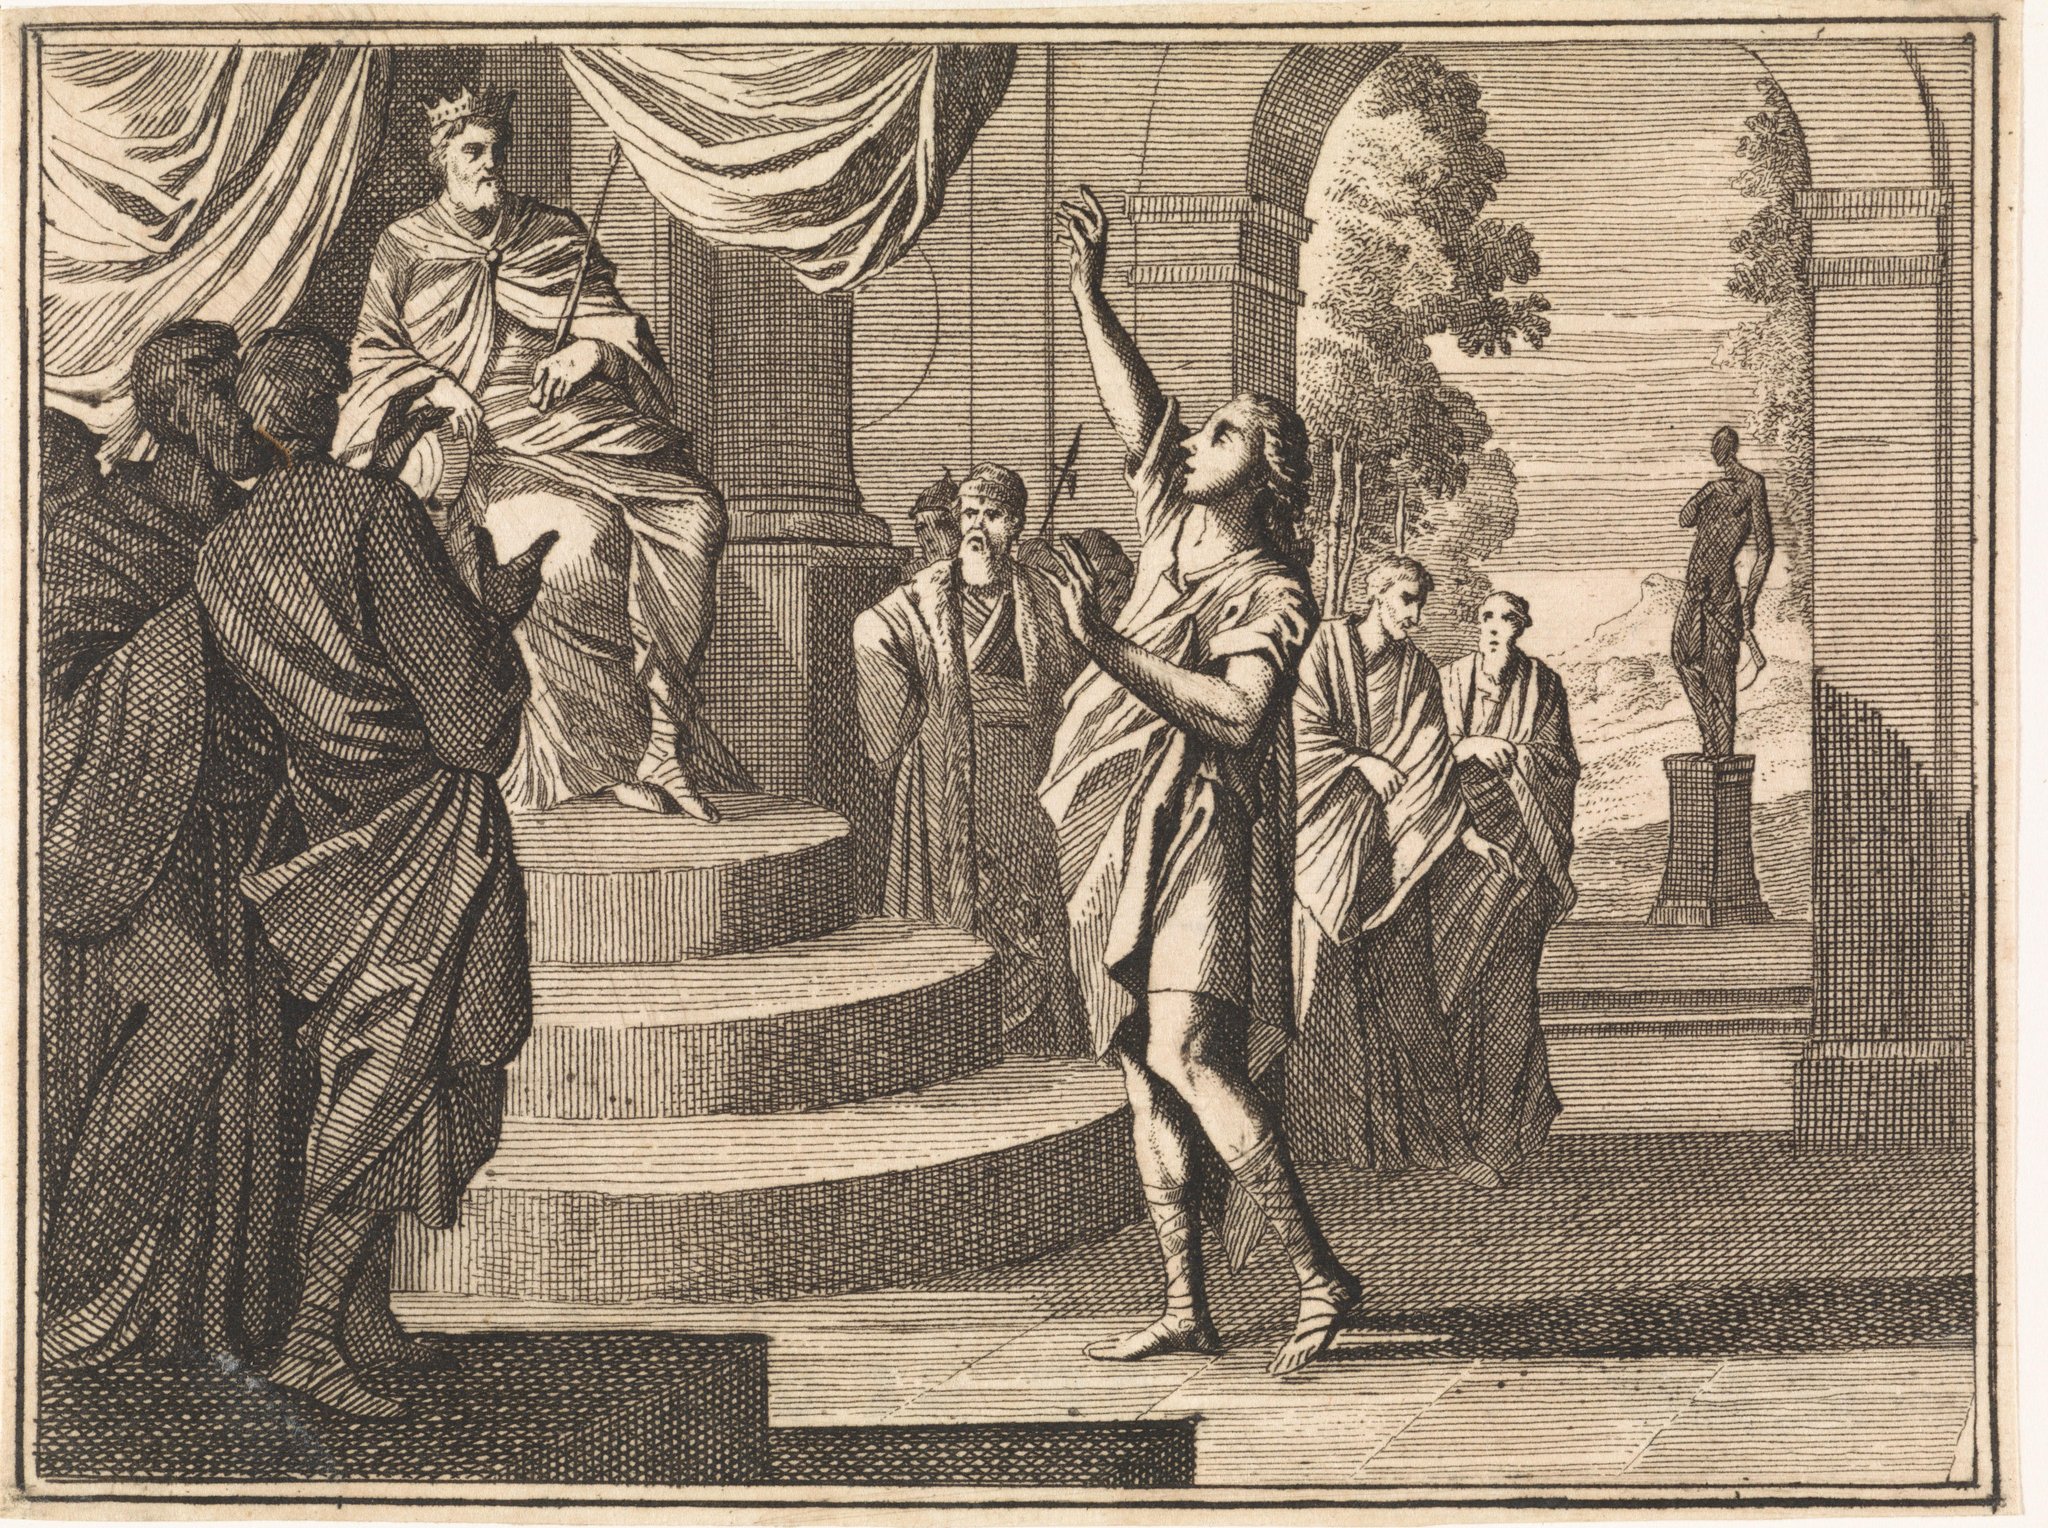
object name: print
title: Jozef verklaart de dromen van de farao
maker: caspar luyken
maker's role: draughtsman, print maker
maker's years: 1672-1708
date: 1712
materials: paper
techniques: etching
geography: amsterdam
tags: joseph interpreting pharaoh's dreams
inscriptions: collector's mark: Lugt 2228, number: ‘37’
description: Illustratie uit: Luyken, Jan. De schriftuurlyke geschiedenissen en gelykenissen van het Oude en Nieuwe Verbond, 2 delen. Amsterdam: Wed. Pieter Arentsz II en Cornelis van der Sys, 1712, dl. I.